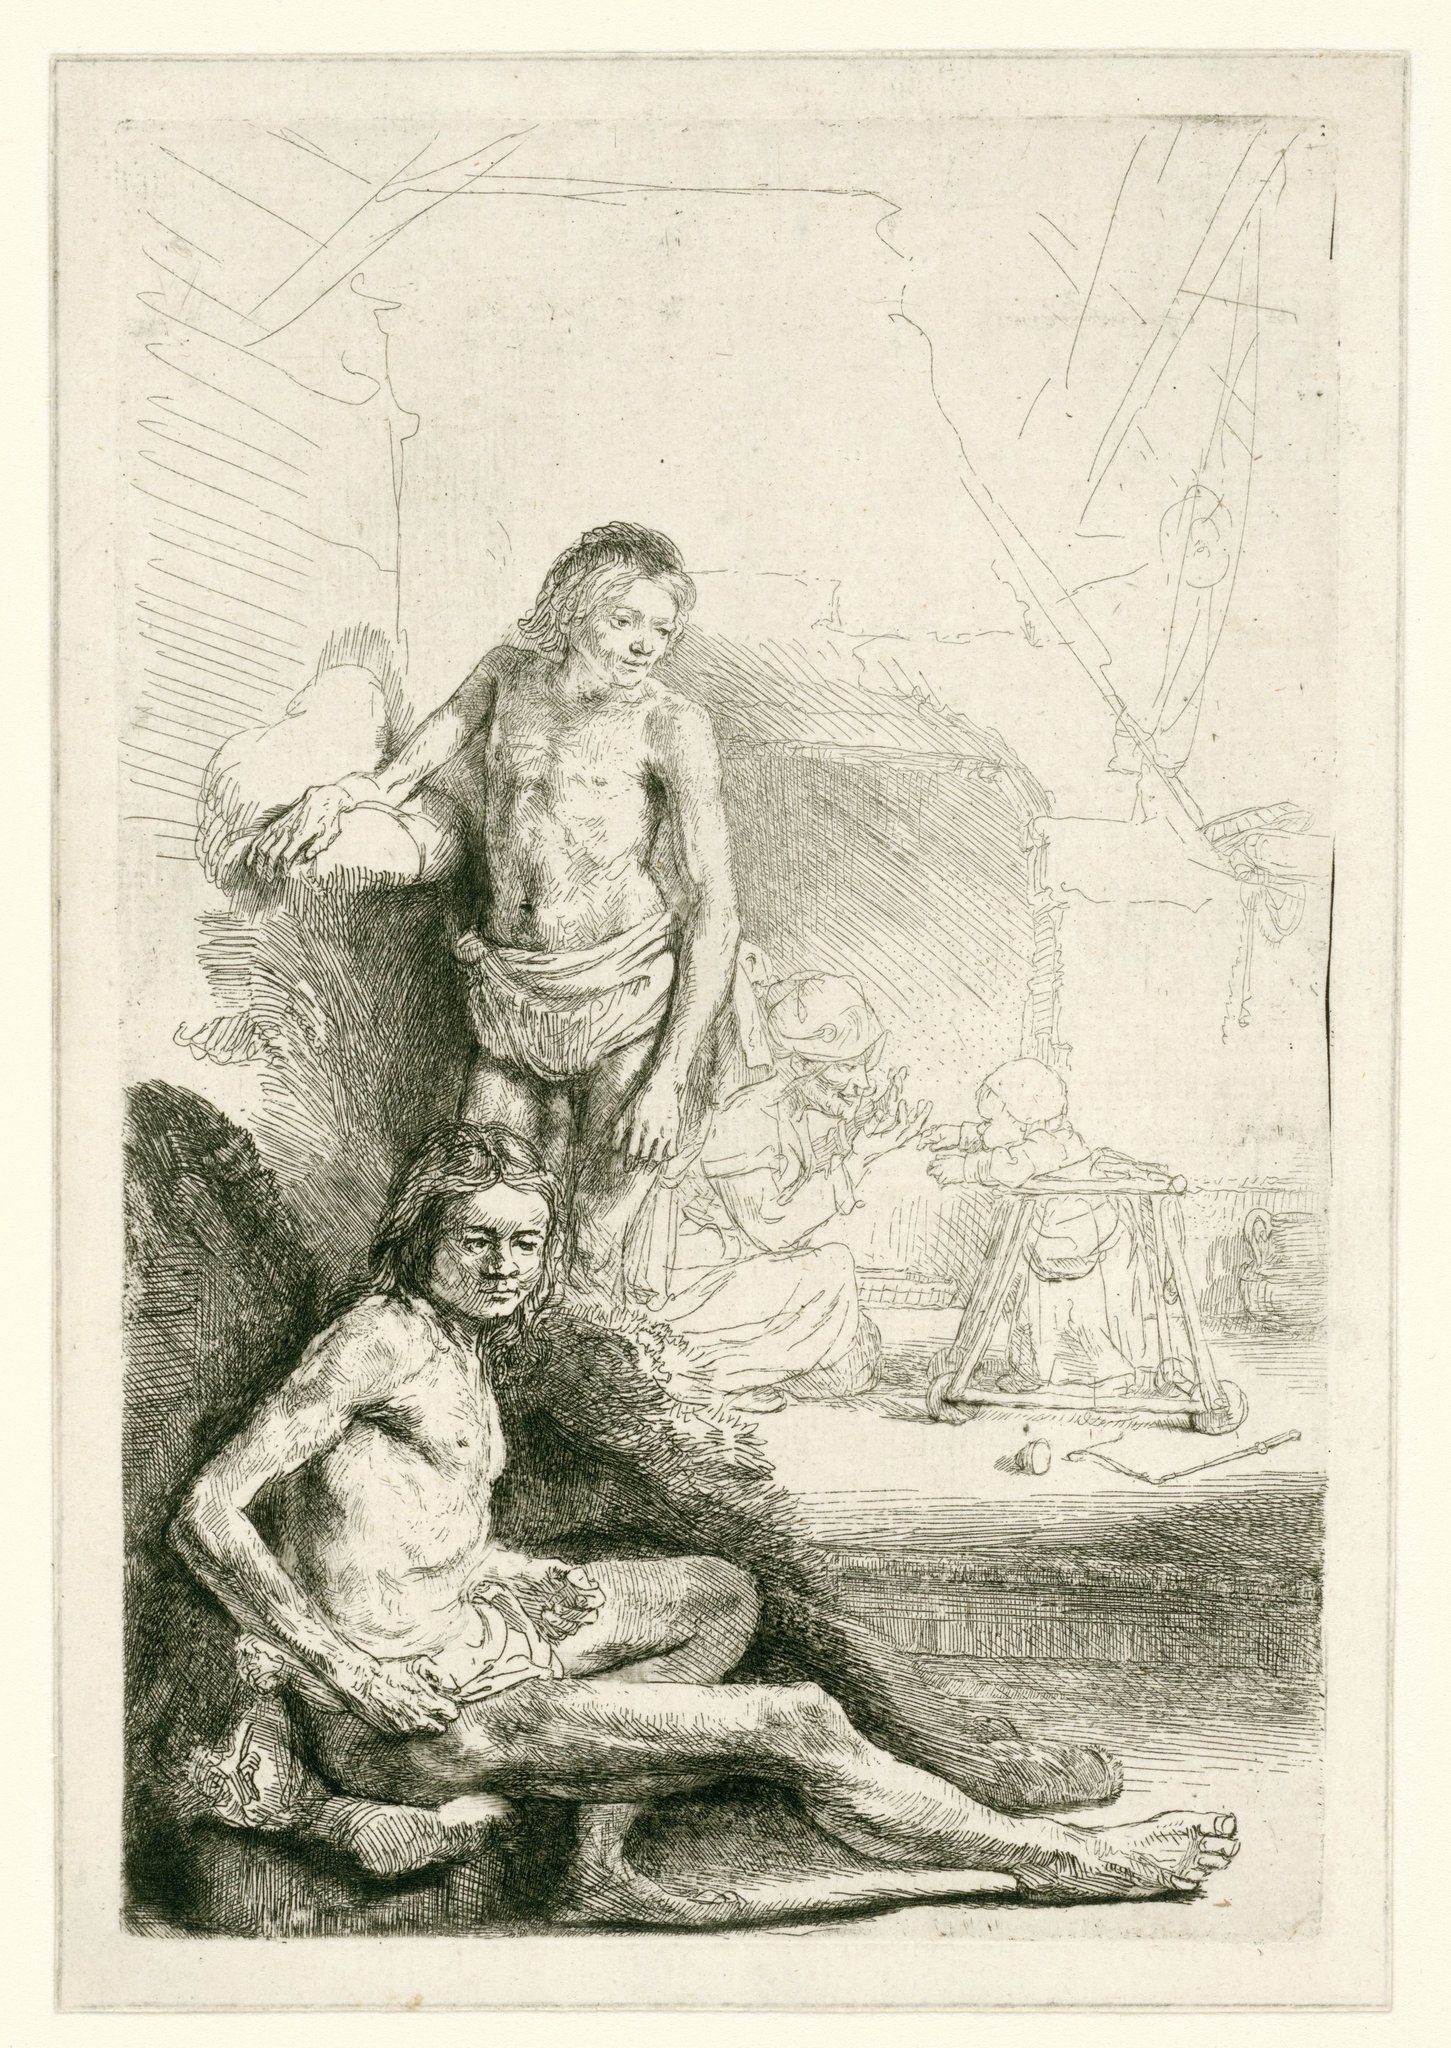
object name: print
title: Male nude, seated and standing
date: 1646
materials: paper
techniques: etching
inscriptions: collector's mark: Lugt 240